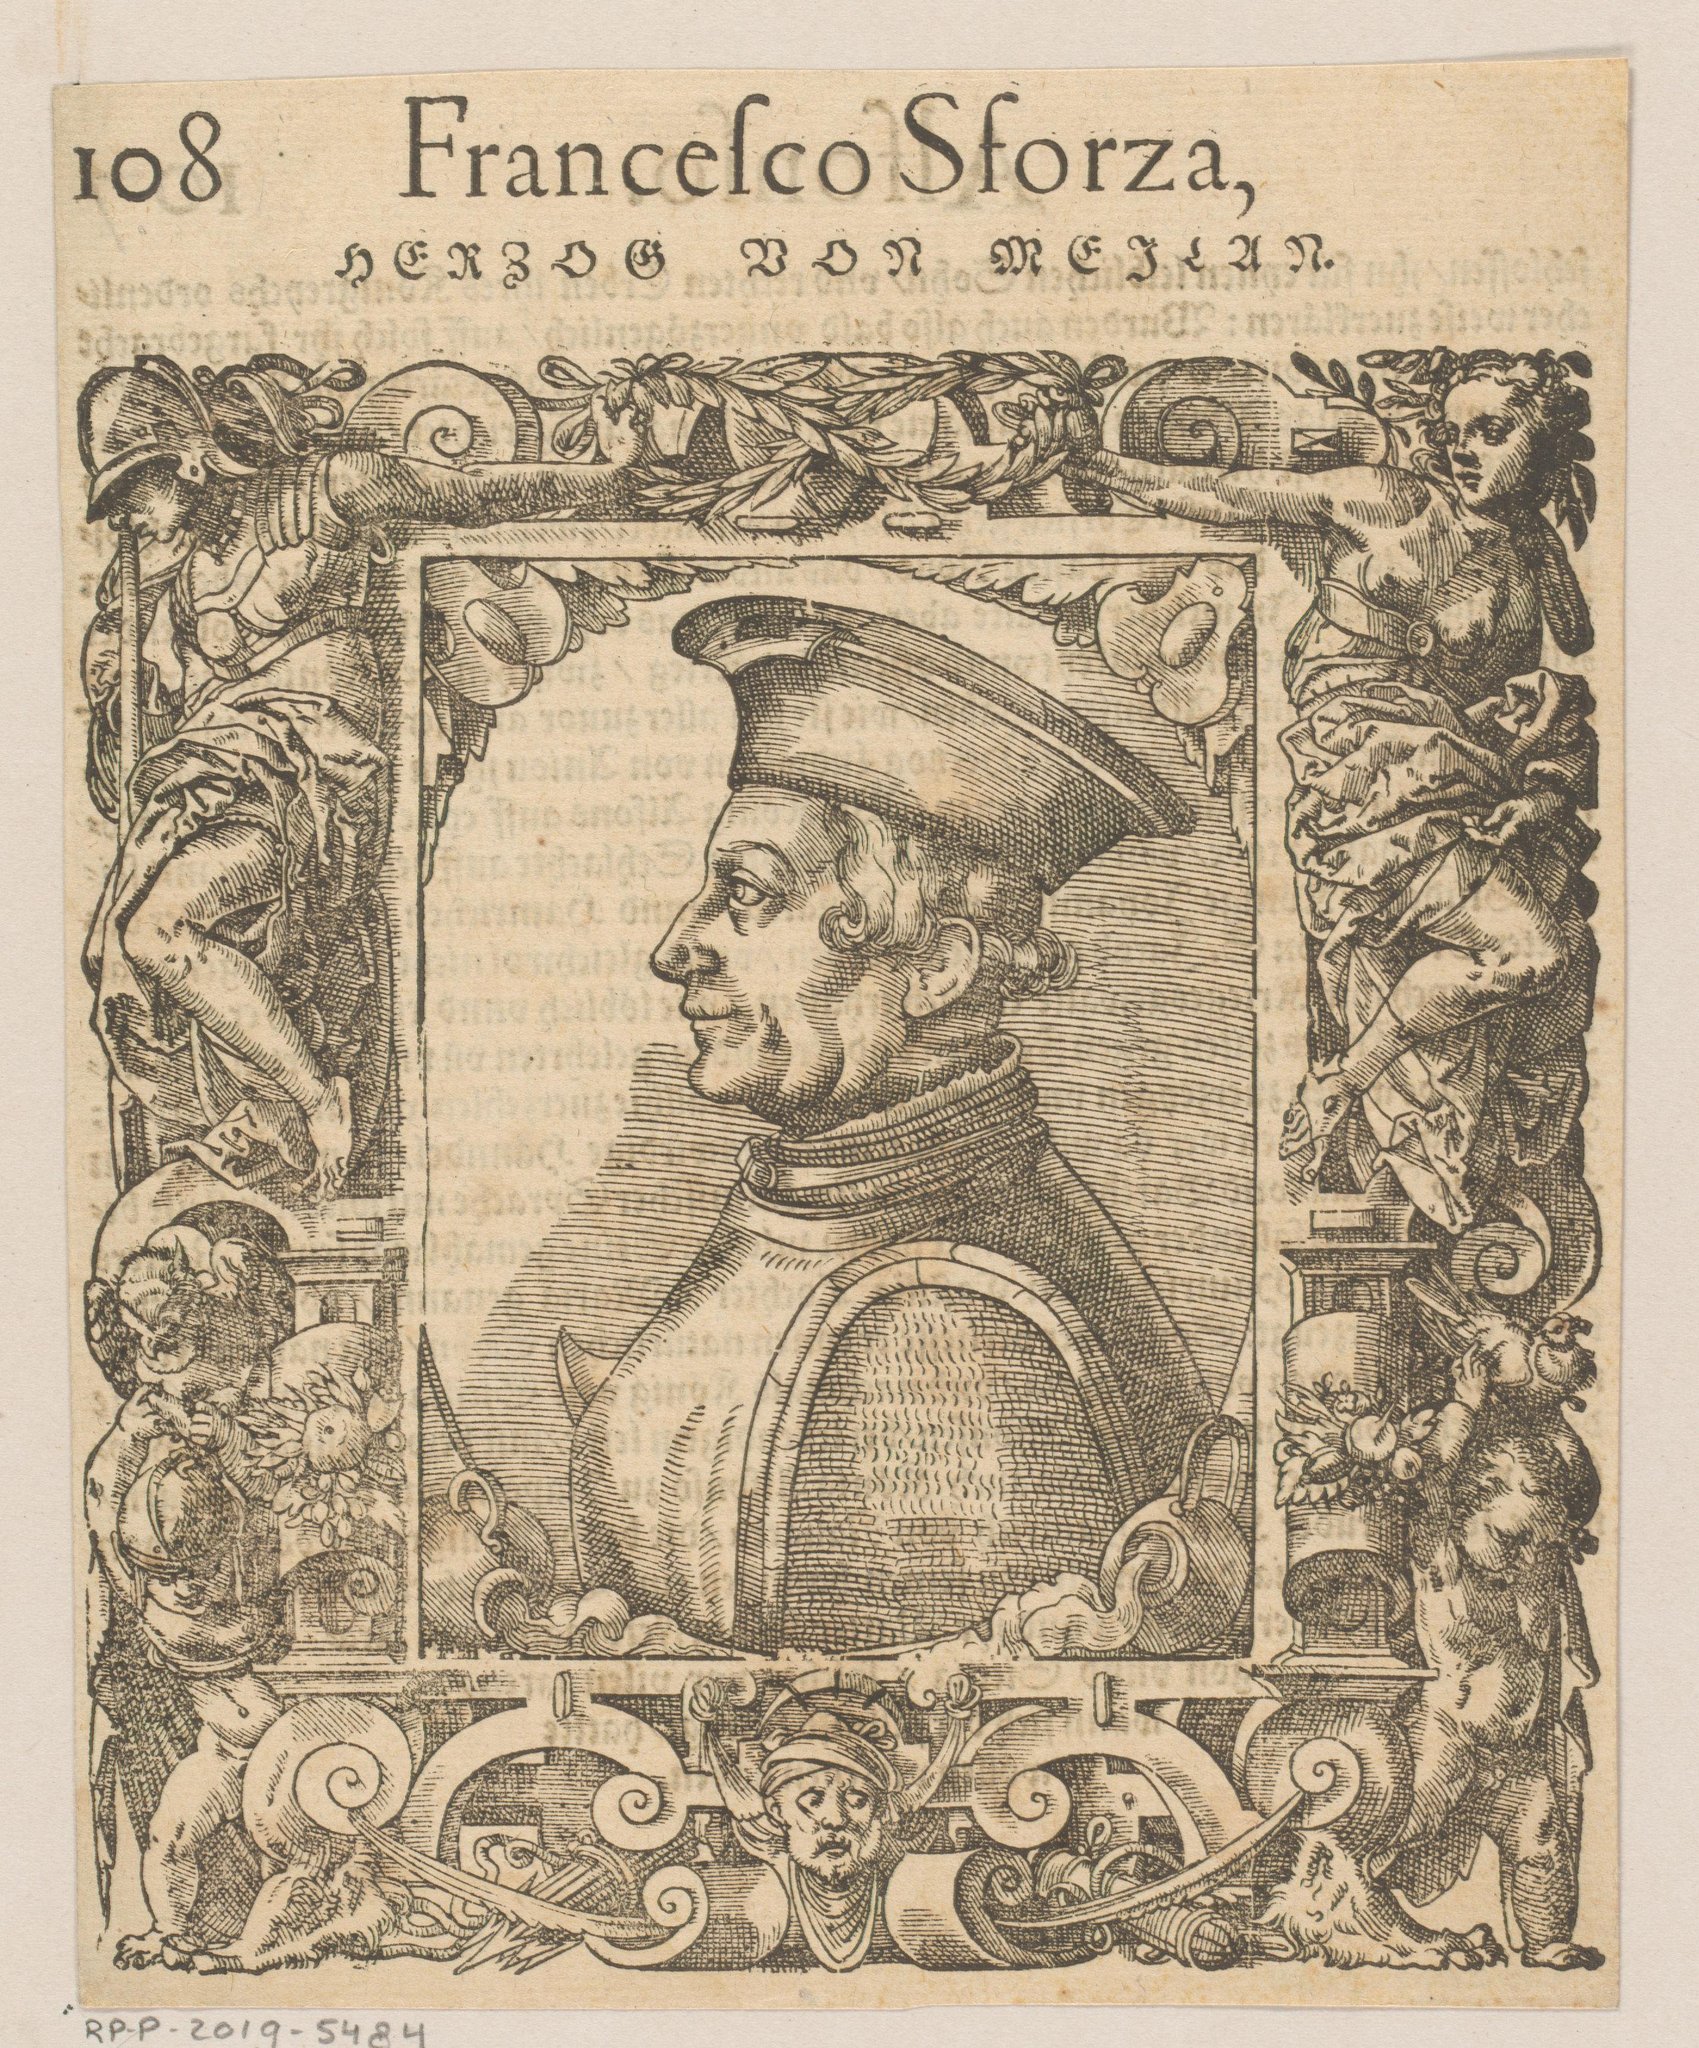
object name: print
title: Portret van Francesco I Sforza, hertog van Milaan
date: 1587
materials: paper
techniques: letterpress printing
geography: basel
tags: historical persons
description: Prent uit: Warhafftiger kurtzer Bericht von mannigerley Kriegs und anderen fürnemen (...). Bazel: Konrad Waldkirch, 1587, p. 108. Prent eerder verschenen in: Giovio, Paolo. Elogia virorum bellica virtute illustrium (...). Bazel: Peter Perna, 1575. Prent mogelijk ook gebruikt in latere publicaties.